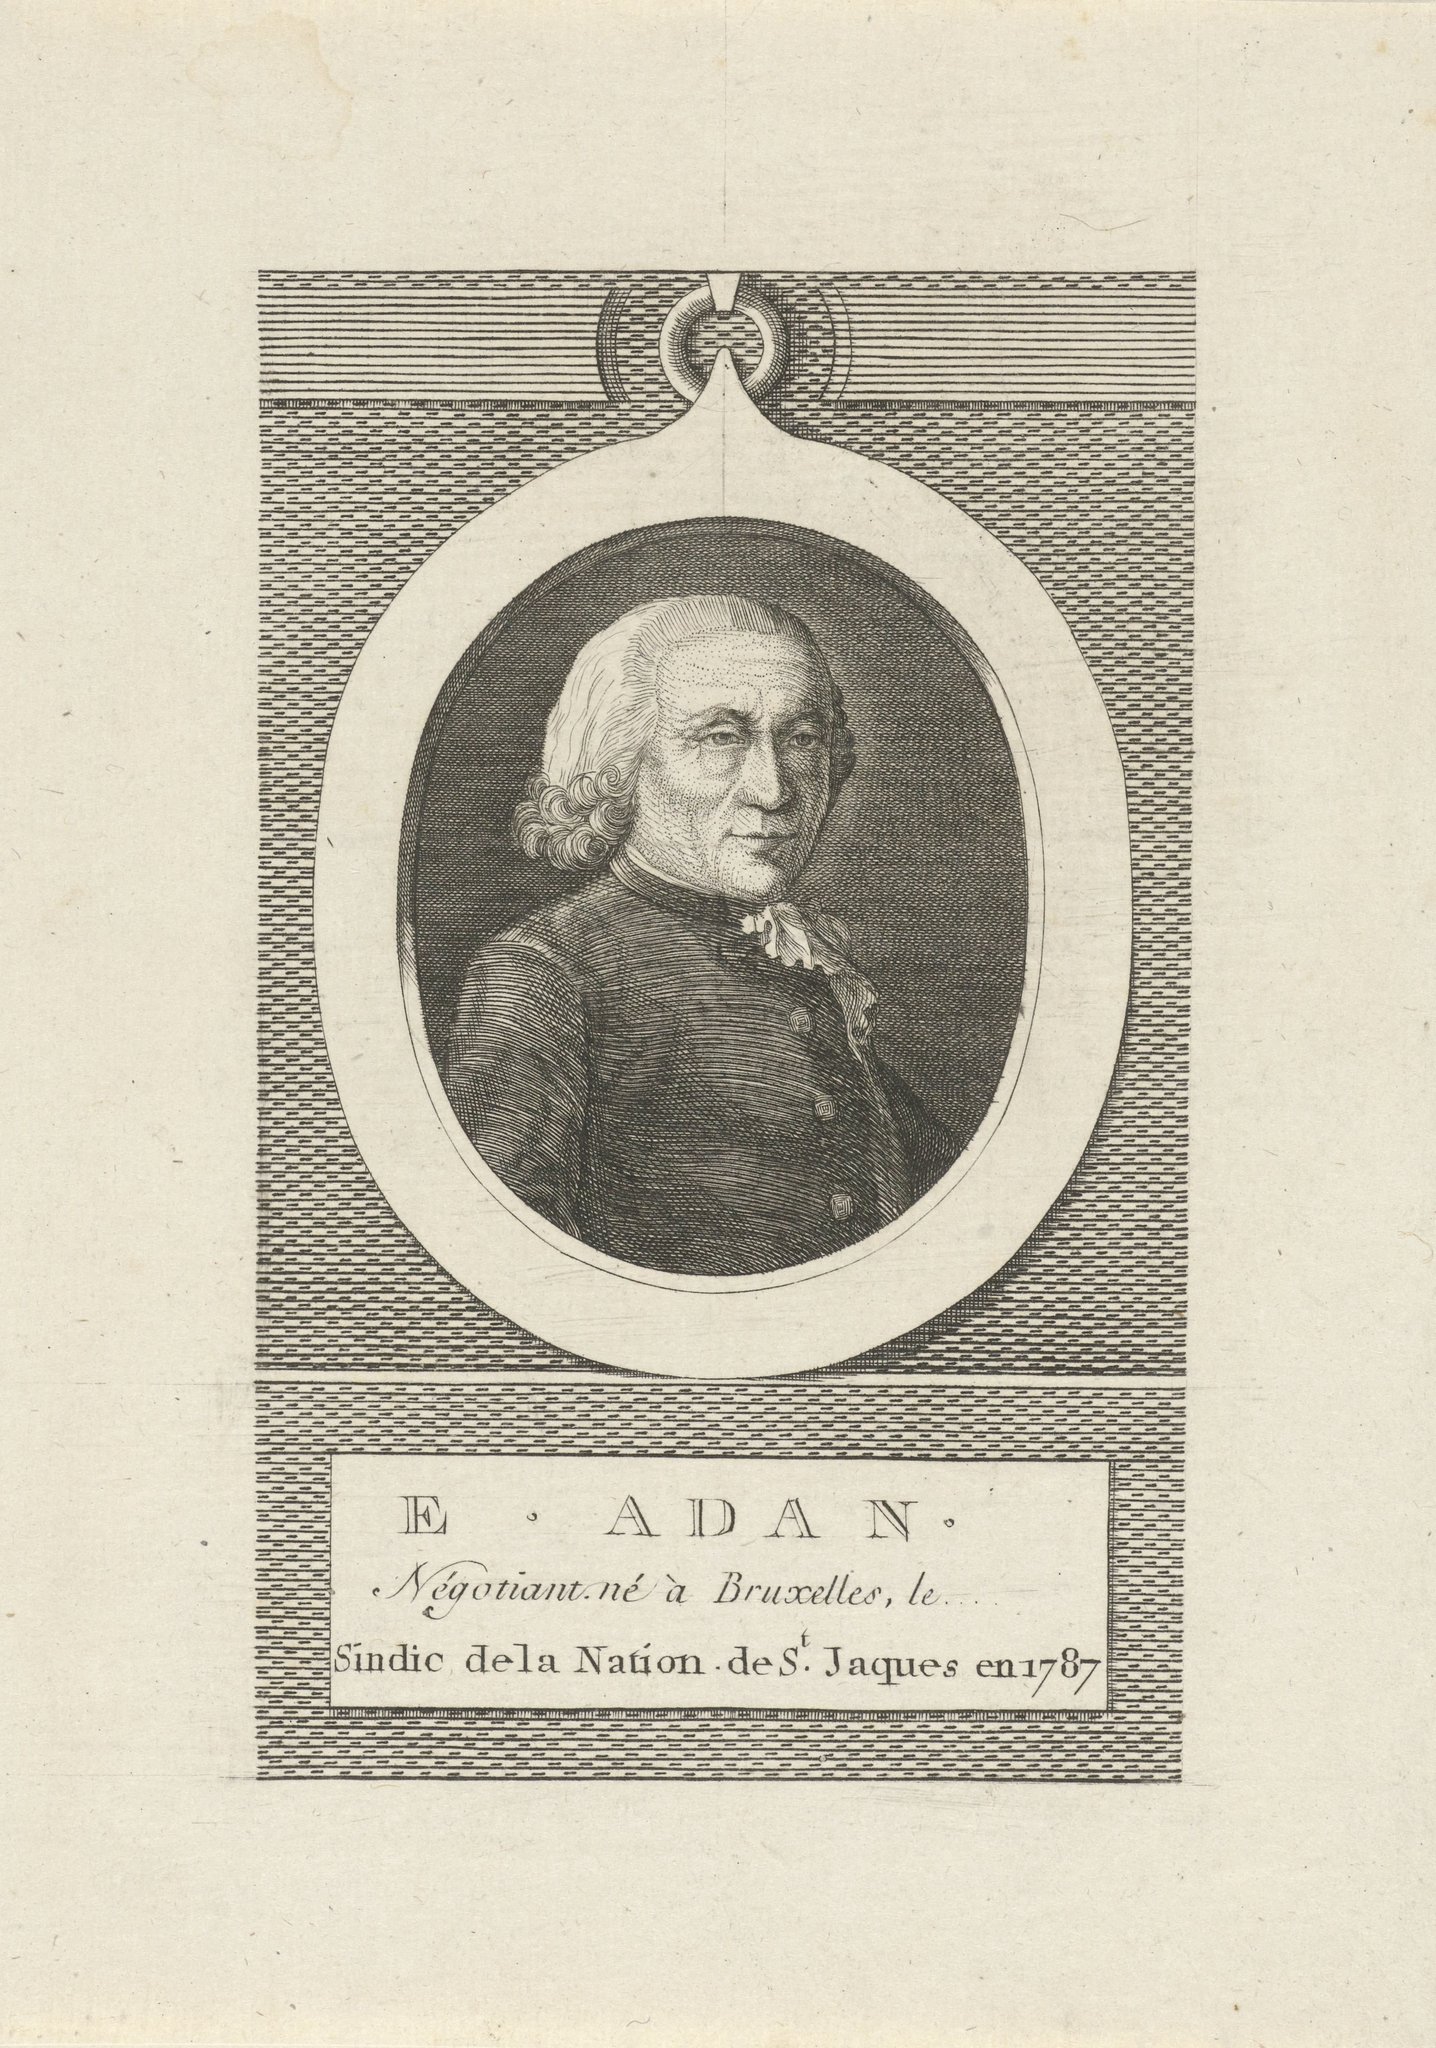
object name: print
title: Portret van E. Adan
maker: j.f. de la rue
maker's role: print maker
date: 1787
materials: paper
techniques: engraving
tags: raadsheer, e. adan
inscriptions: collector's mark: Lugt 2228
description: Portretbuste in ovaal naar rechts van E. Adan, raadsheer van Saint-Jacques, blootshoofds. Onder het portret staan de naam, geboorteplaats en functie van de geportretteerde in het Frans vermeld.